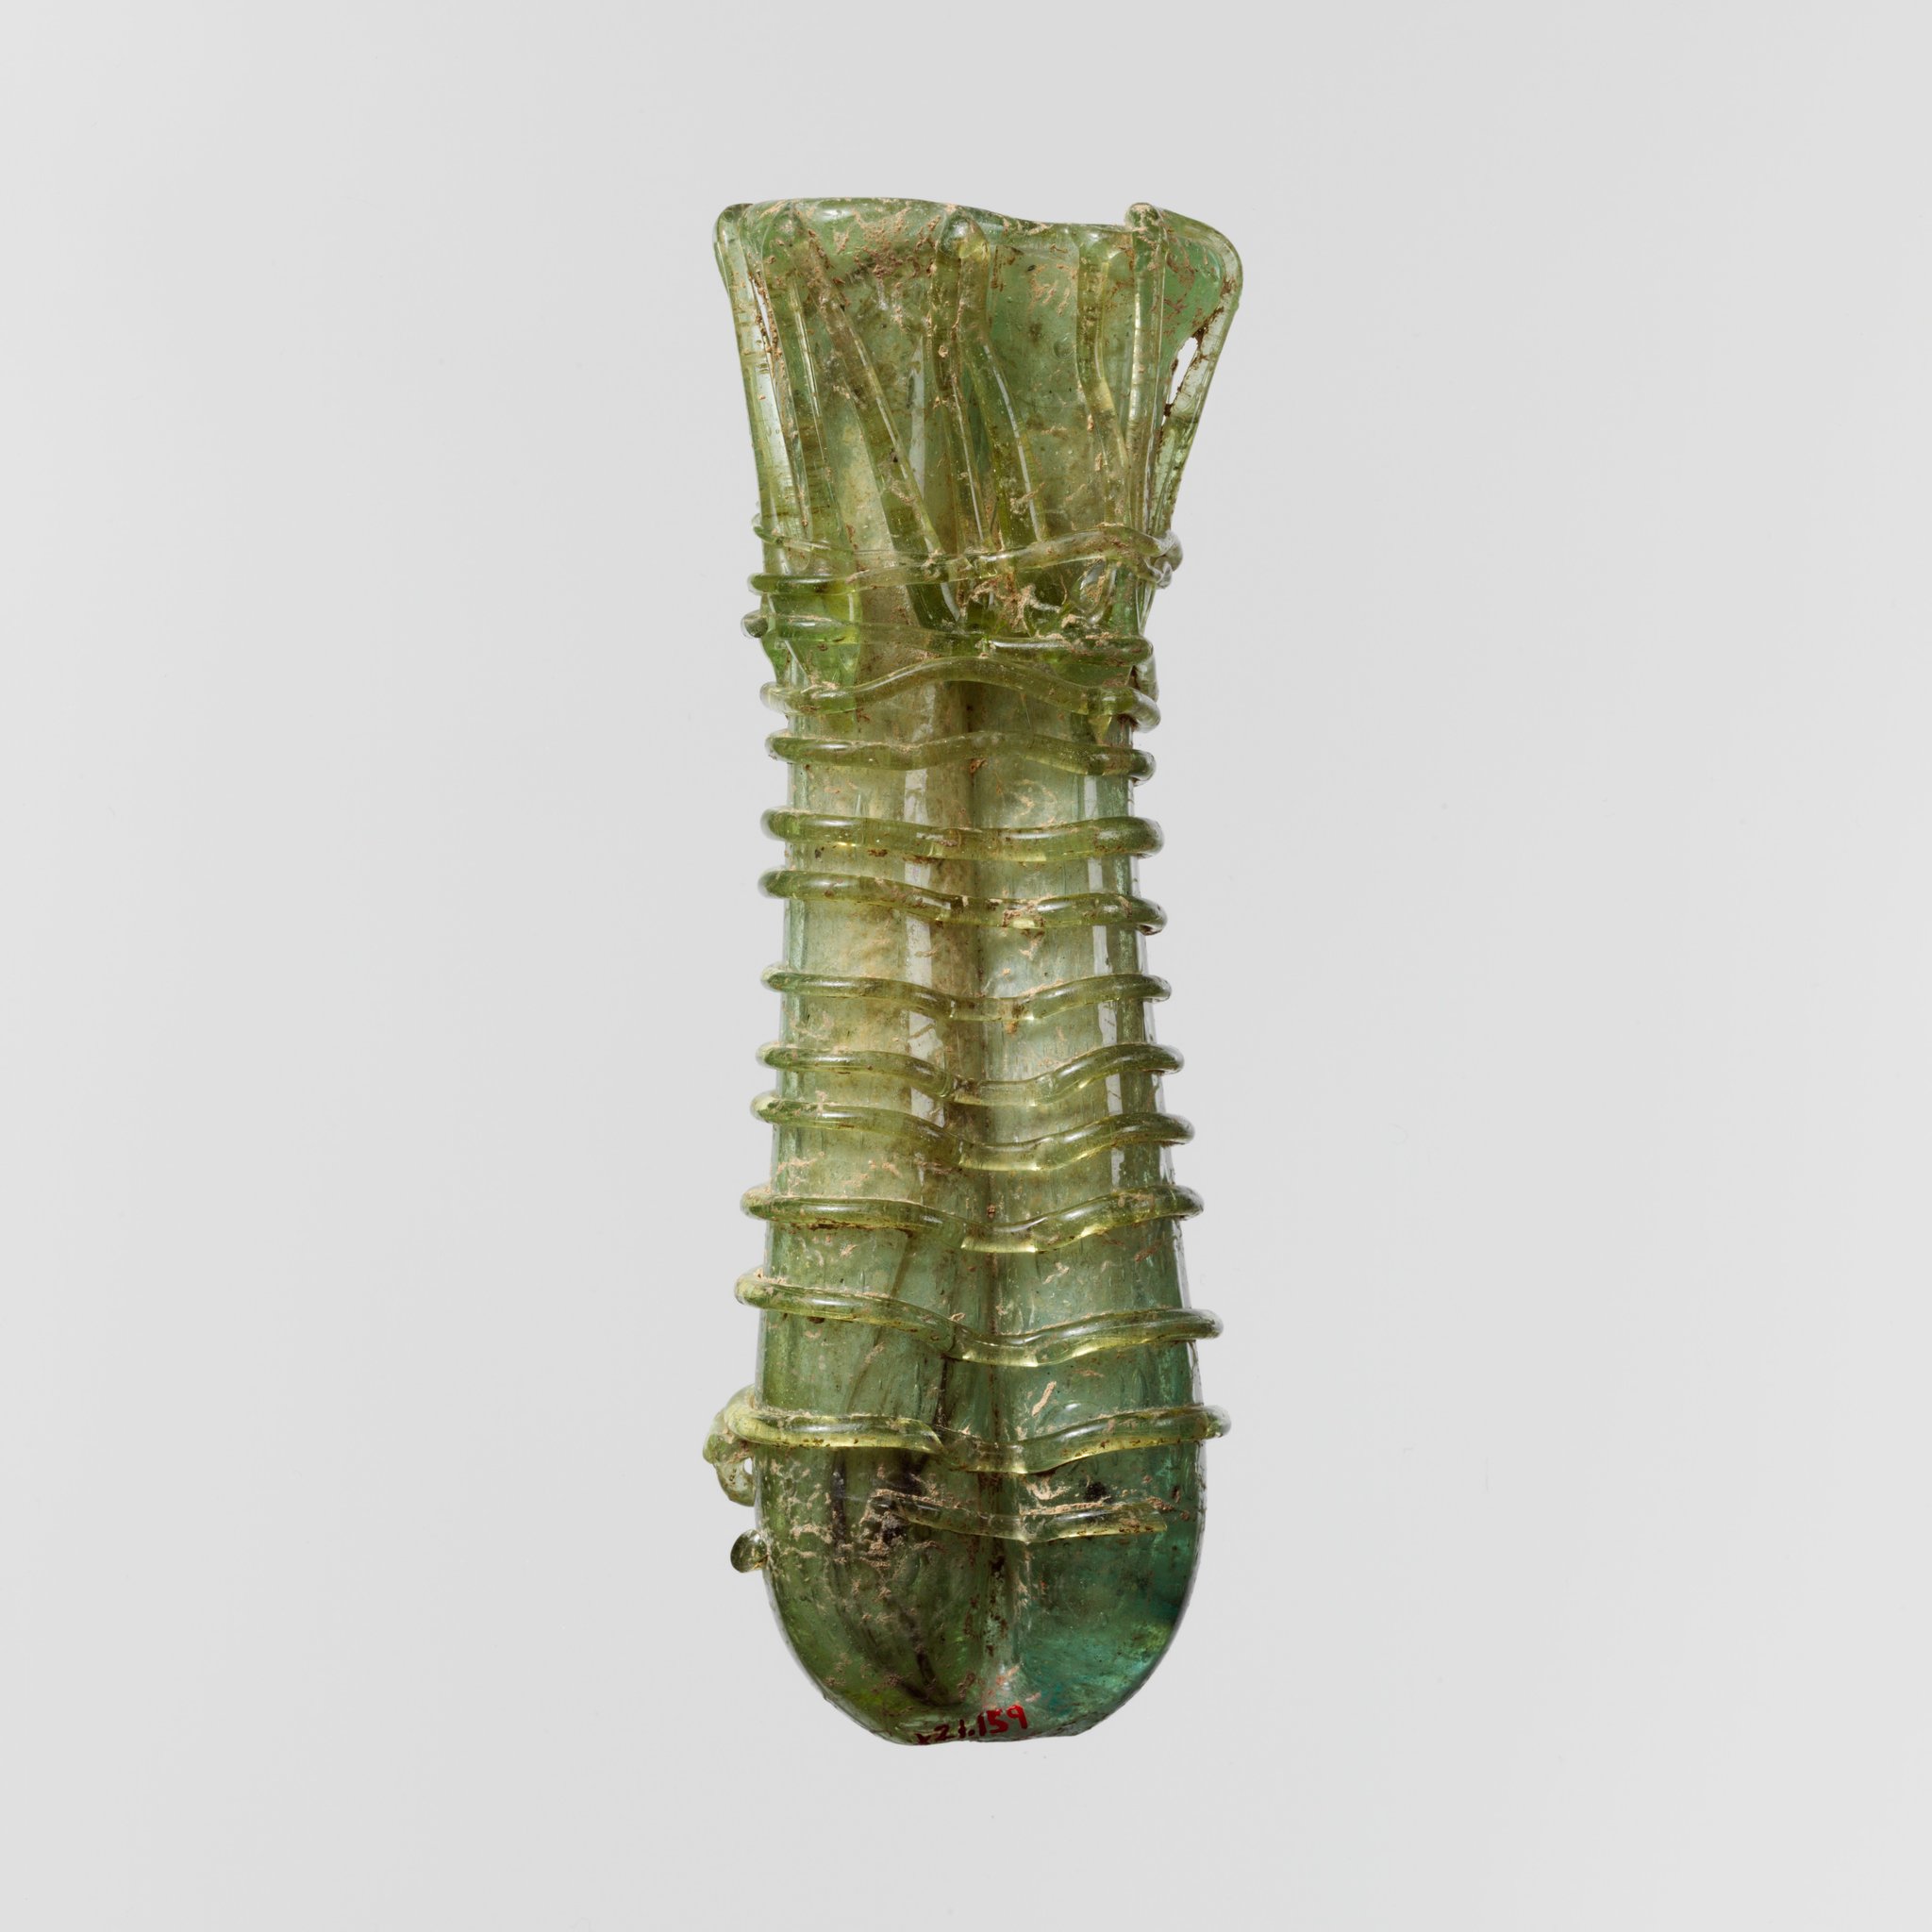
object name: cosmetic flask, double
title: Glass double cosmetic flask (kohl tube)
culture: roman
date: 301-400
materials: glass